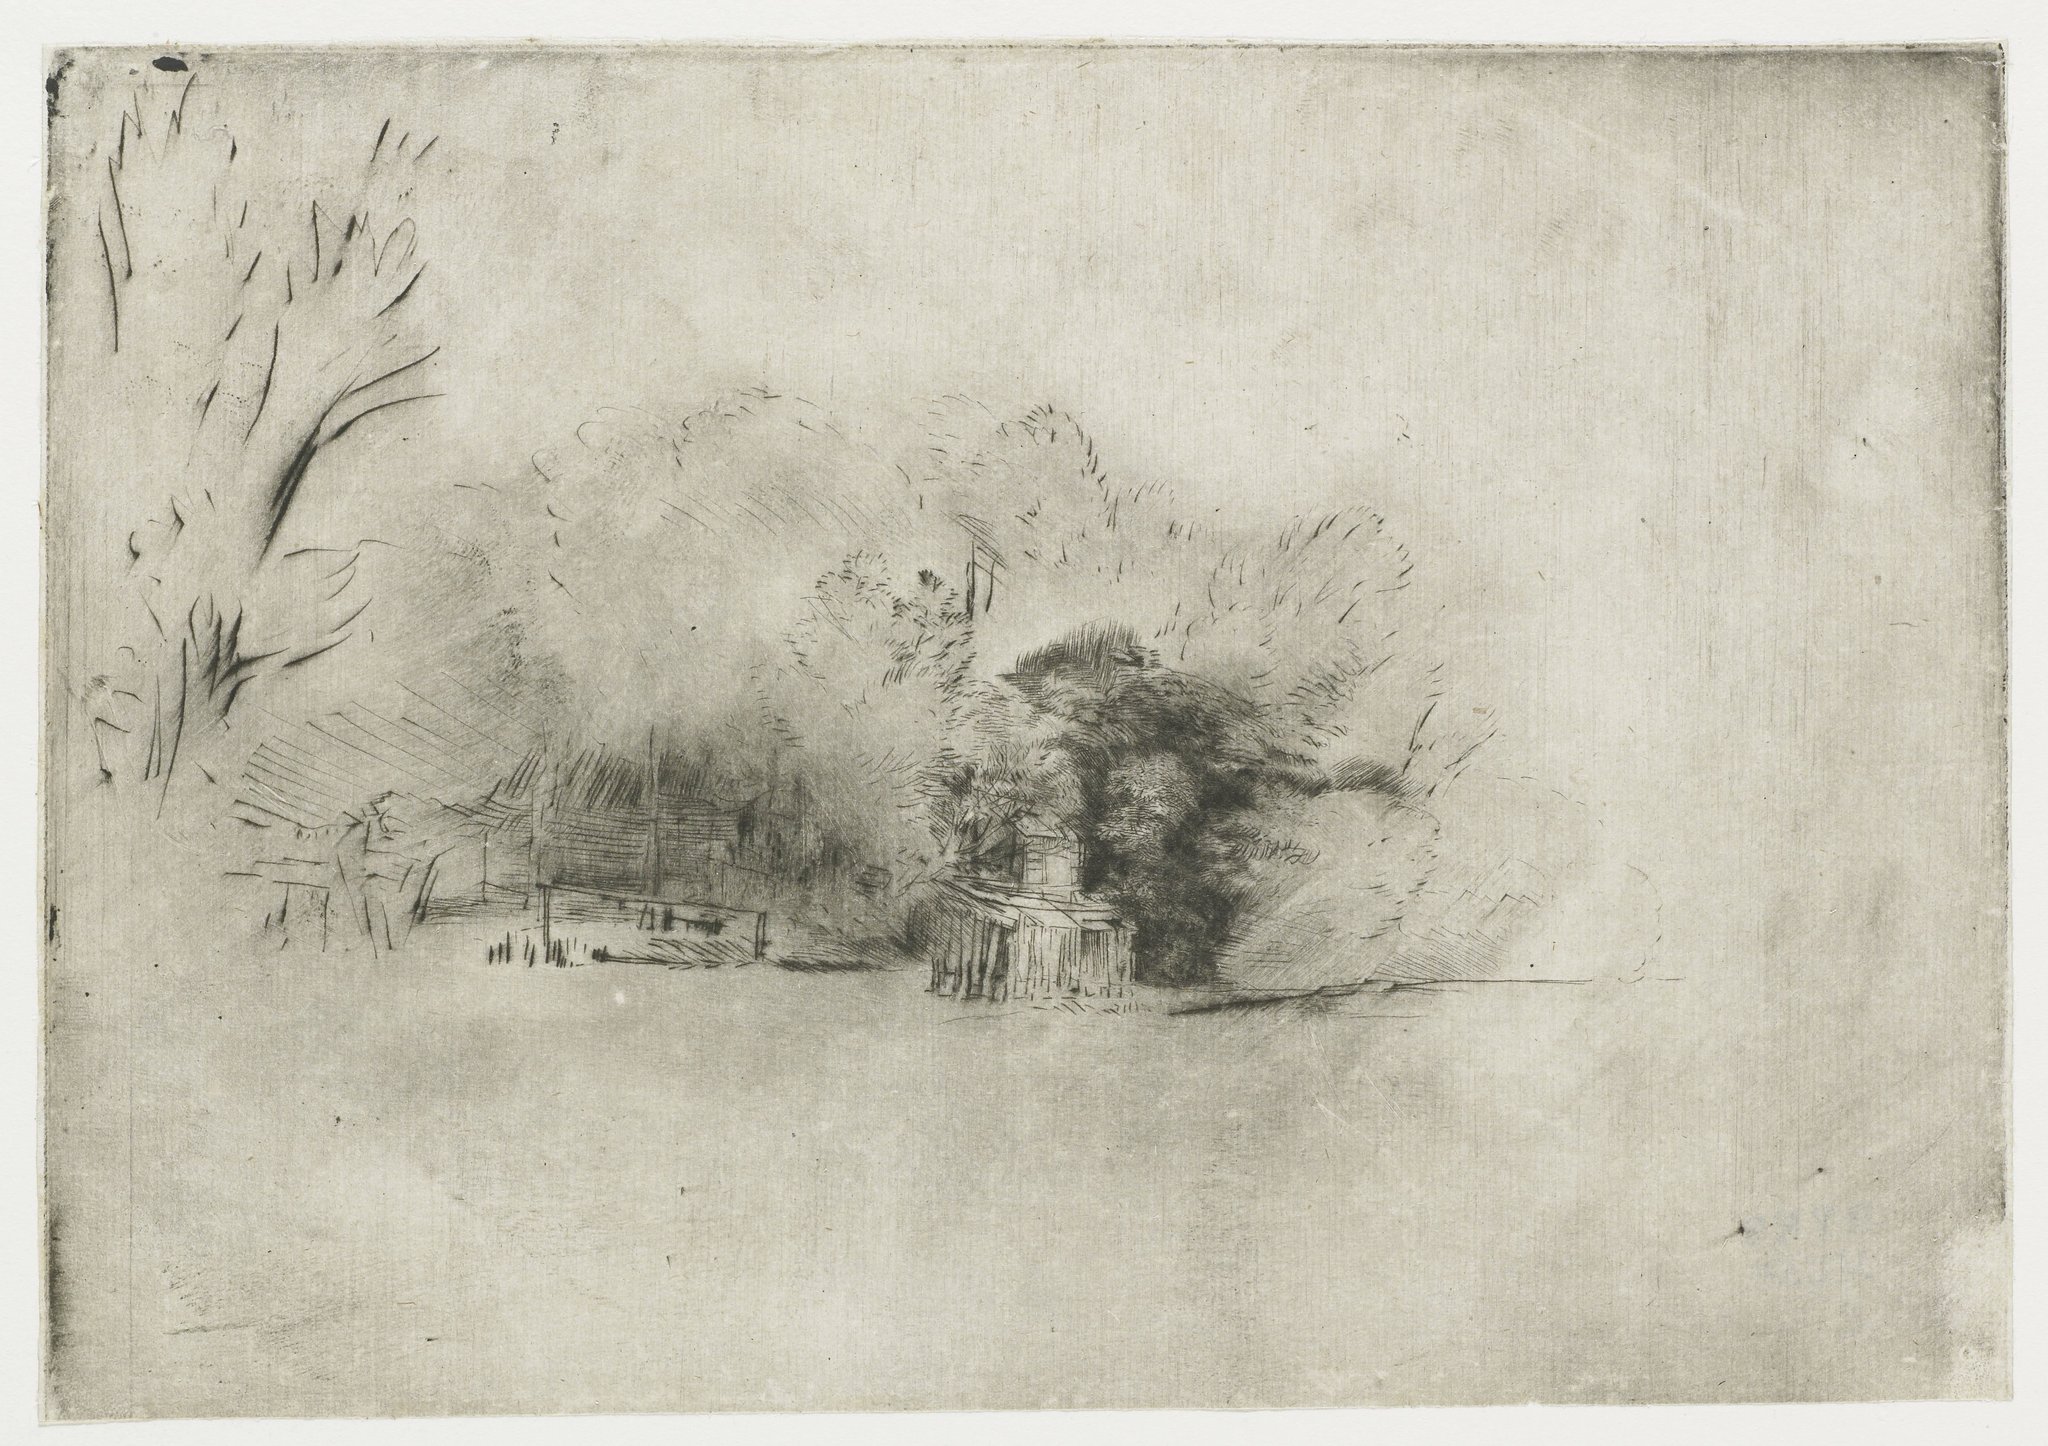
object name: print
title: Farmhouse among Trees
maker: rembrandt van rijn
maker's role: draughtsman, painter, print maker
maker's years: 1606-1669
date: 1652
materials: paper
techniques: drypoint, intaglio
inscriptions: mark: Lugt 2165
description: With the needle Rembrandt scratched powerful incisions directly on the copper plate; these bold lines underscore the tall tree at the left. He used less force for the trees surrounding the cottage and the vista at the right. This sketchiness recalls the style he used when drawing in nature. Rembrandt would translate such a sketch done out of doors into a print.